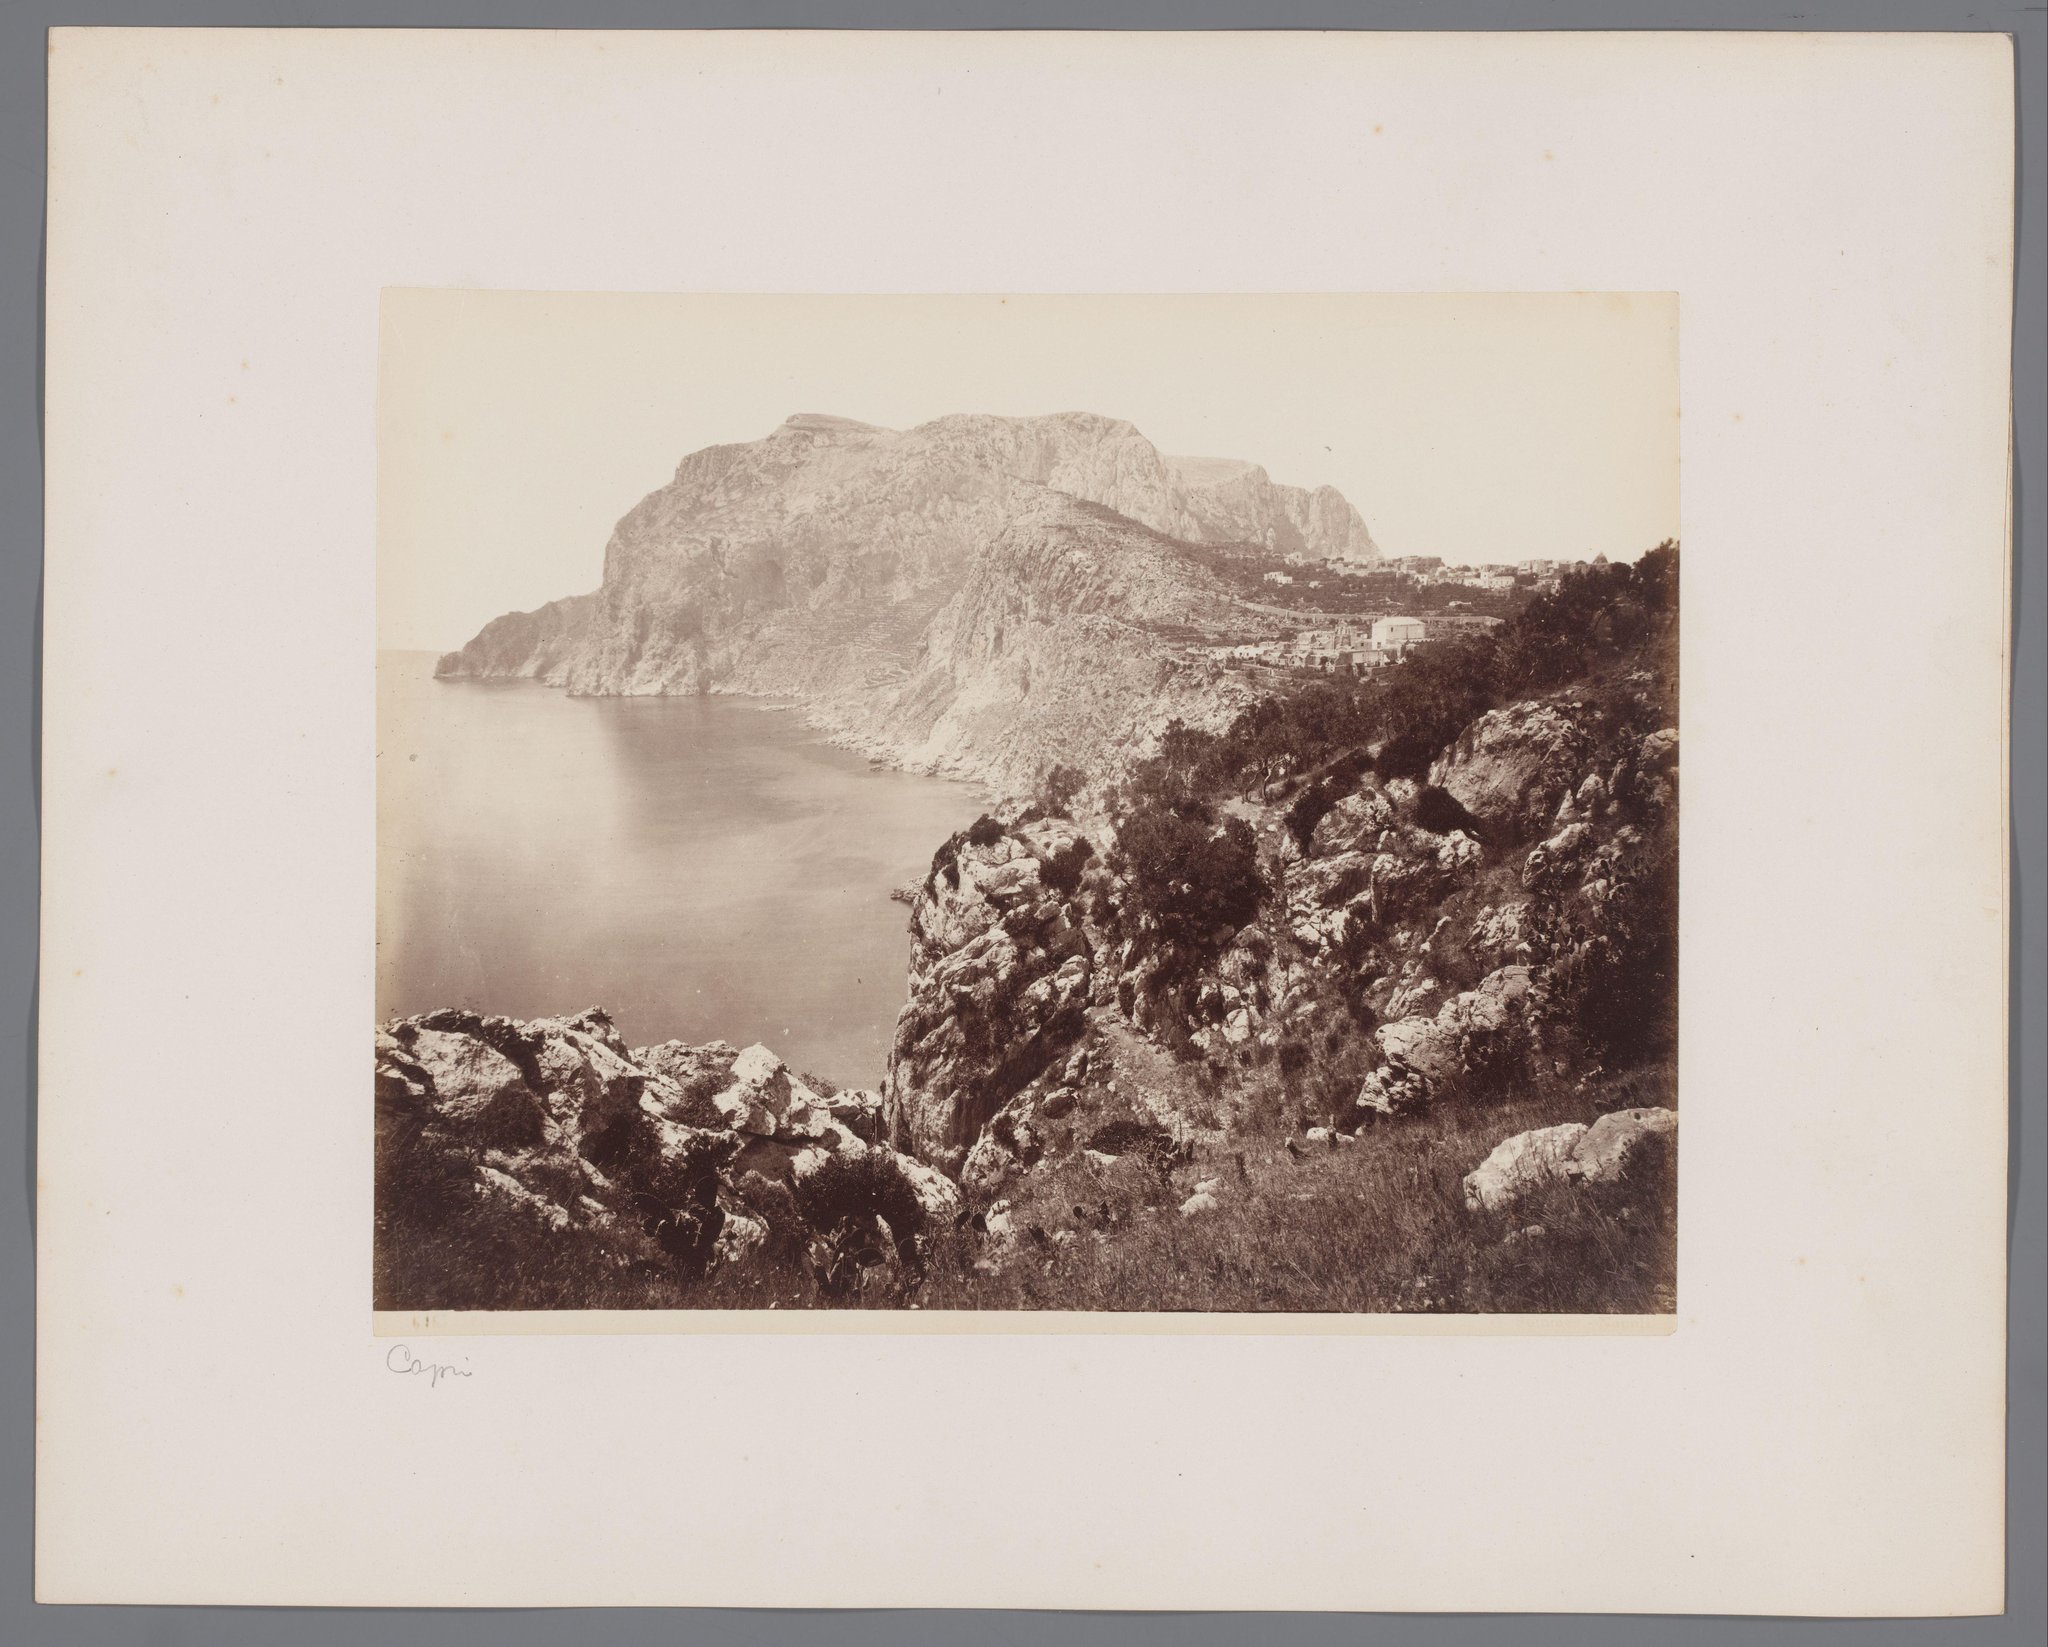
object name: photograph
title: Capri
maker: giorgio sommer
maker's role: fotograaf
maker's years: 1834-1914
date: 1857-1914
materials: cardboard, paper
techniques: albumen print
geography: capri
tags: gulf, bay, capri, isola di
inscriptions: number: ‘[...]’